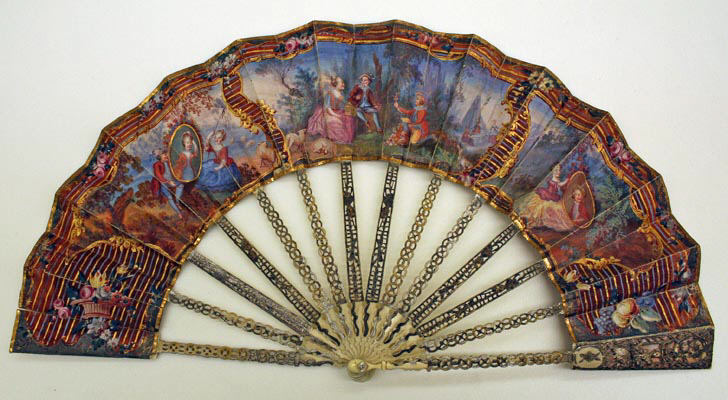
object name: fan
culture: french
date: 1701-1800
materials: gold, ivory, paper, silver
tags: men,women